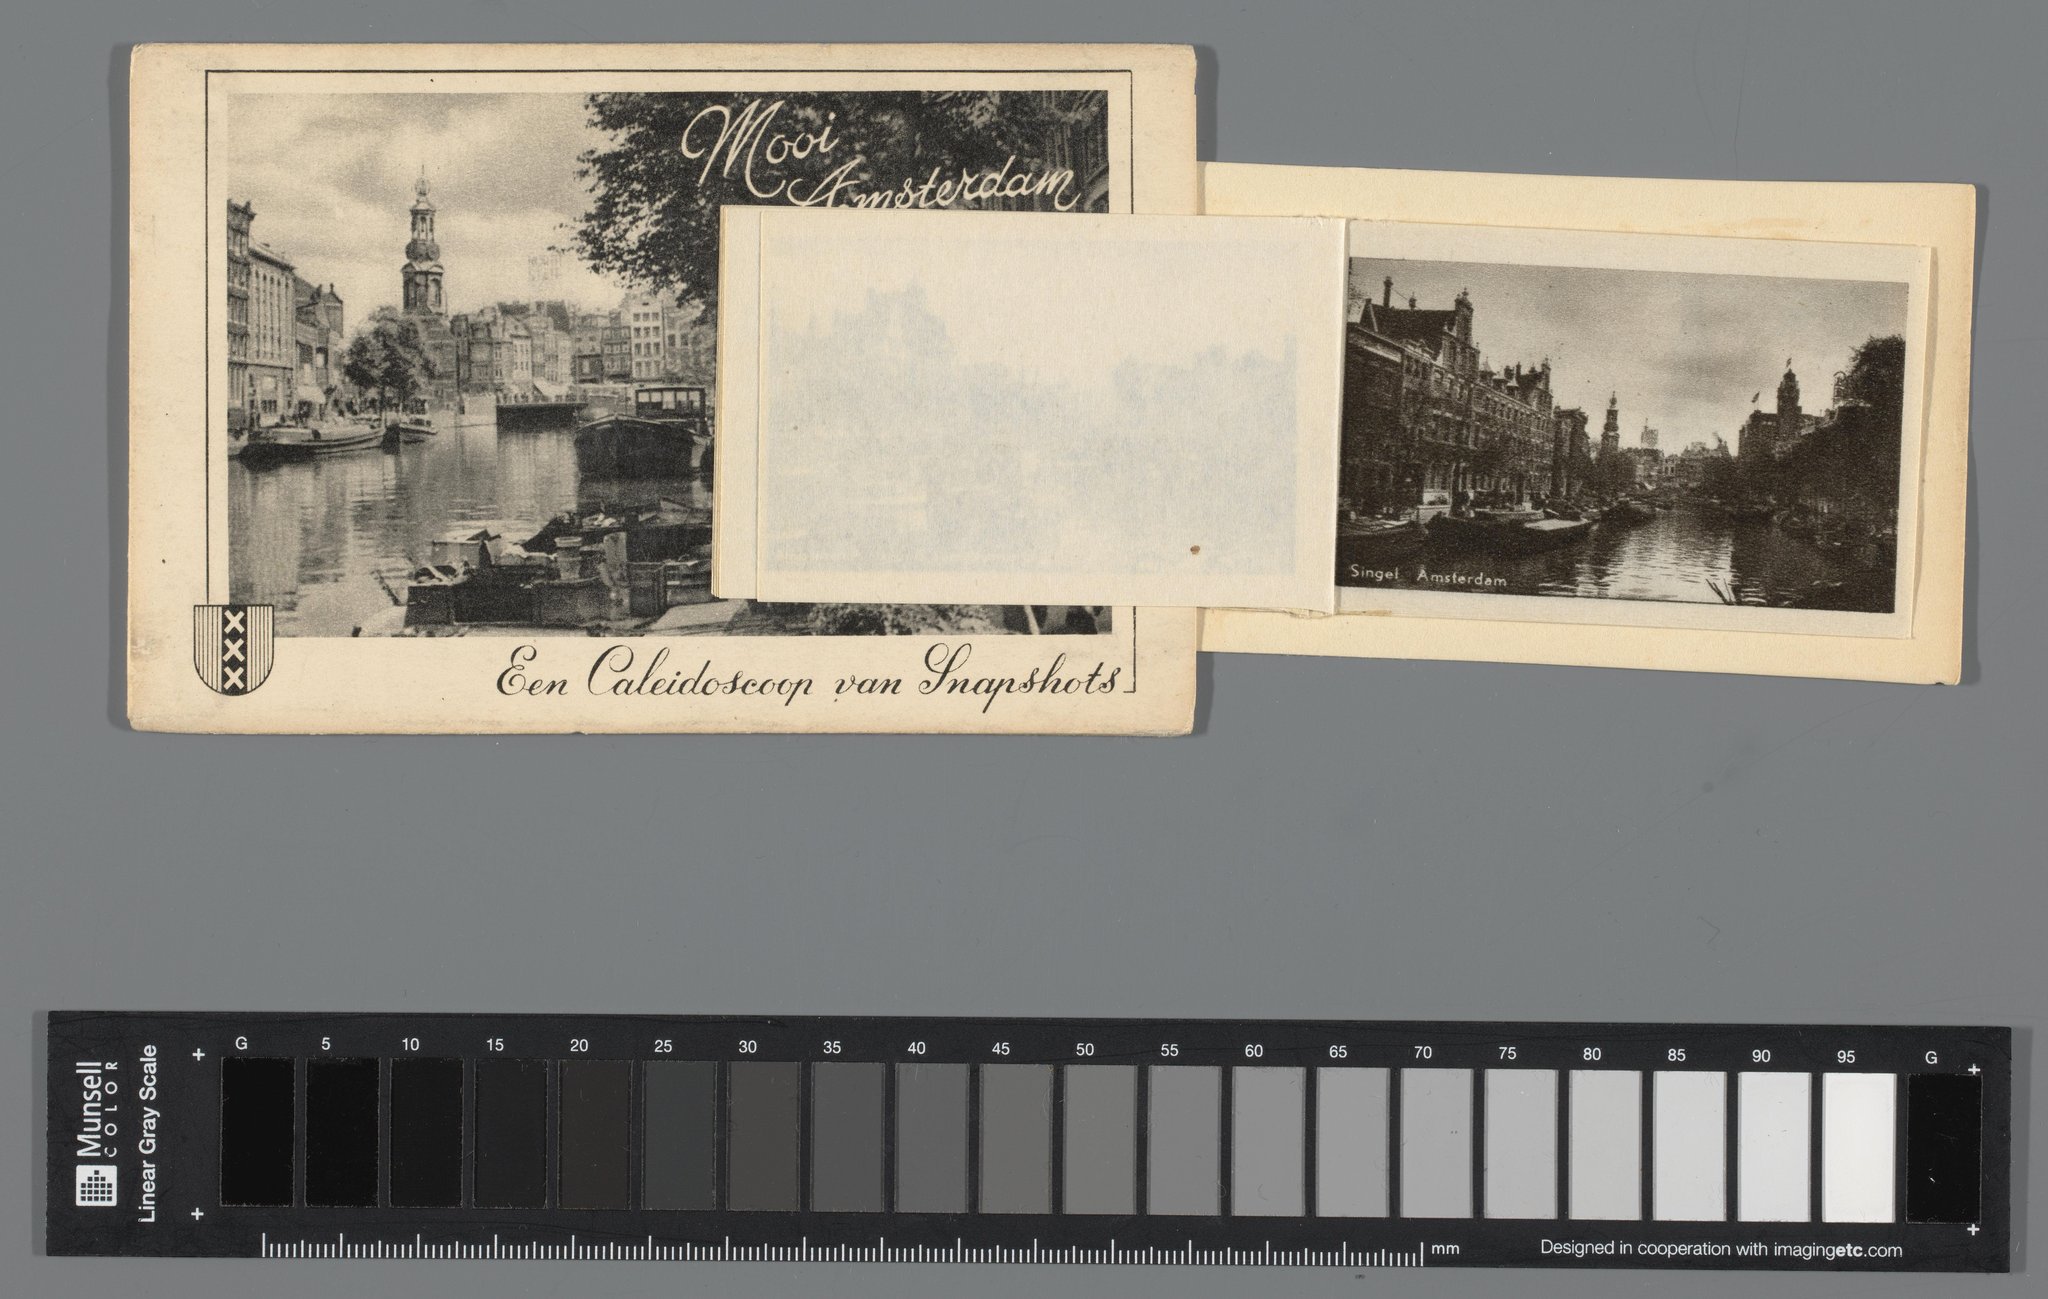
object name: photomechanical print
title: Singel Amsterdam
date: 1920-1950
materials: paper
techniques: rotogravure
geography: amsterdam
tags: canals, waters (in city)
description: Deze prent maakt deel uit van een omslag met tien prenten.